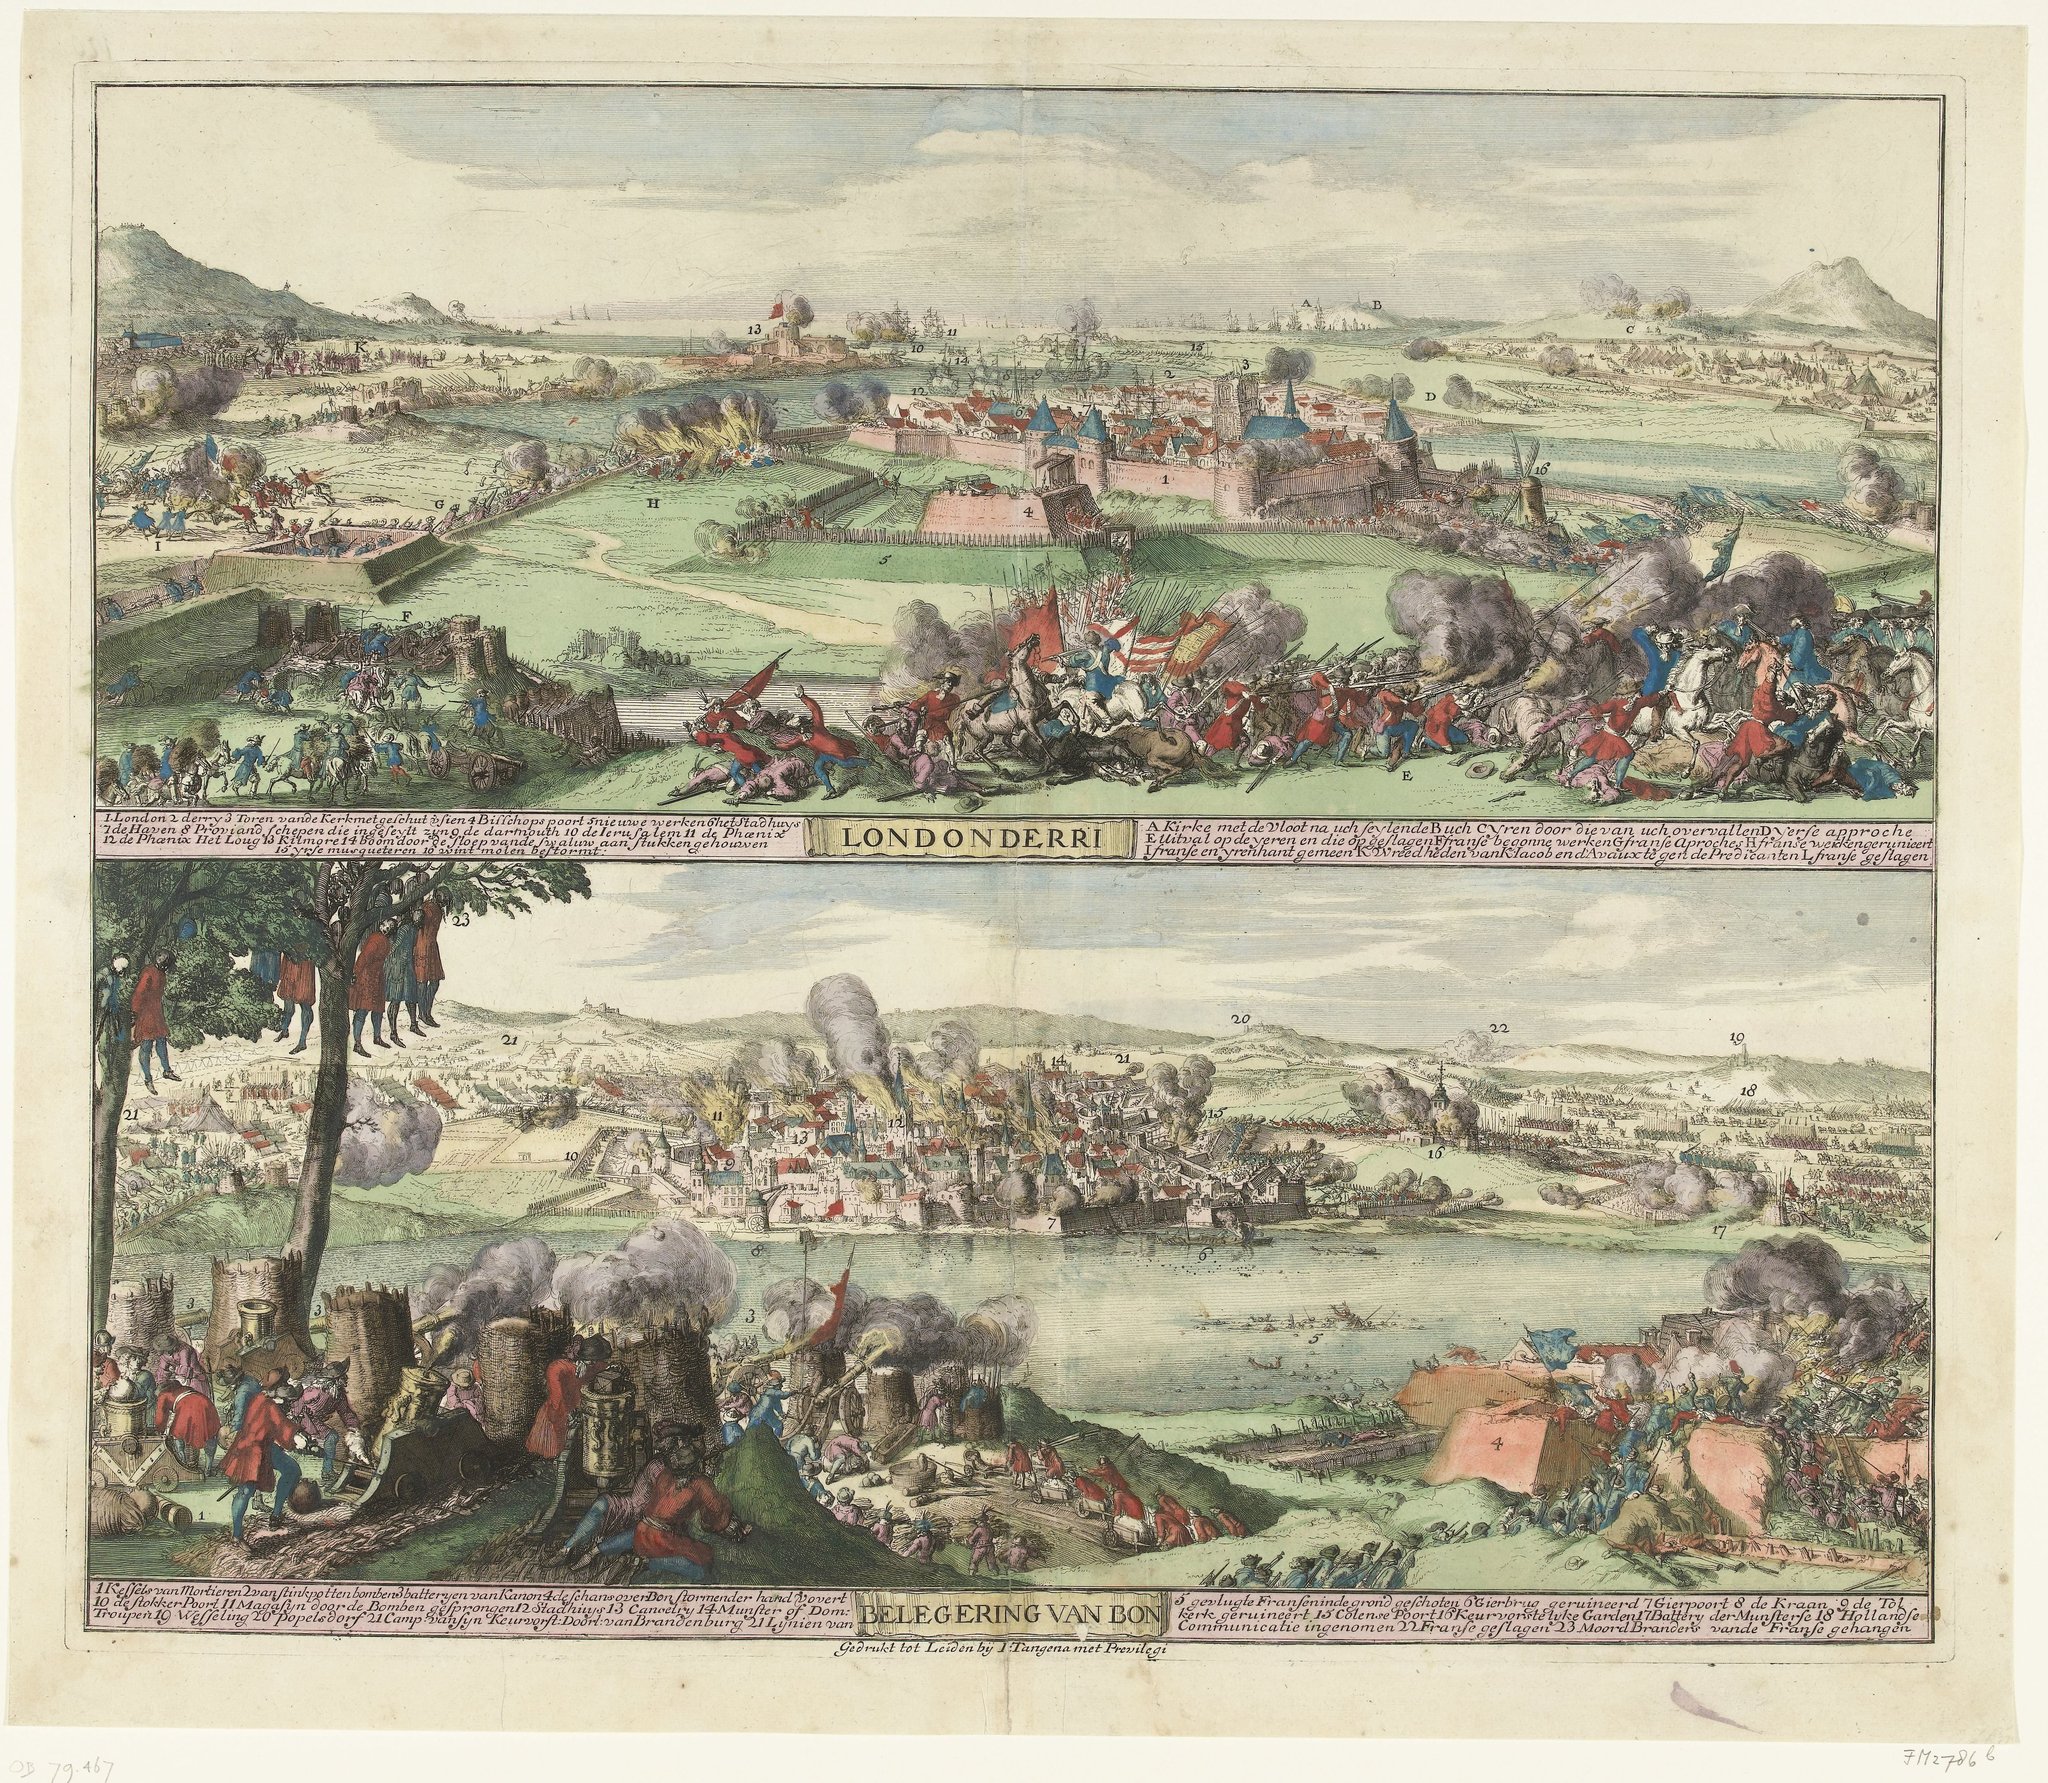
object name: print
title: Londonderri / Belegering van Bon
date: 1689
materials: paper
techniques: etching, hand coloring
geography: northern netherlands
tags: jacobus ii (koning van engeland en schotland), william iii (prince of orange and king of england, scotland, and ireland), siege, position war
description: Blad met twee voorstellingen. Boven de belegering van Londonderry door de troepen van koning Jacobus II, van 18 april tot 28 juli 1689. Gezicht op de stad met de vestingwerken, op de voorgrond gevechten, in de verte de zee. Onder de voorstelling de legenda's 1-16 en A-L in het Nederlands. Onder de belegering en verovering van Bonn door de geallieerde troepen op de Fransen, 29 juni 1689. Gezicht op de stad met de vestingwerken, op de voorgrond beschietingen. Links een boom met door de Fransen gehangen moordbranders. Onder de voorstelling de legenda 1-22 in het Nederlands.